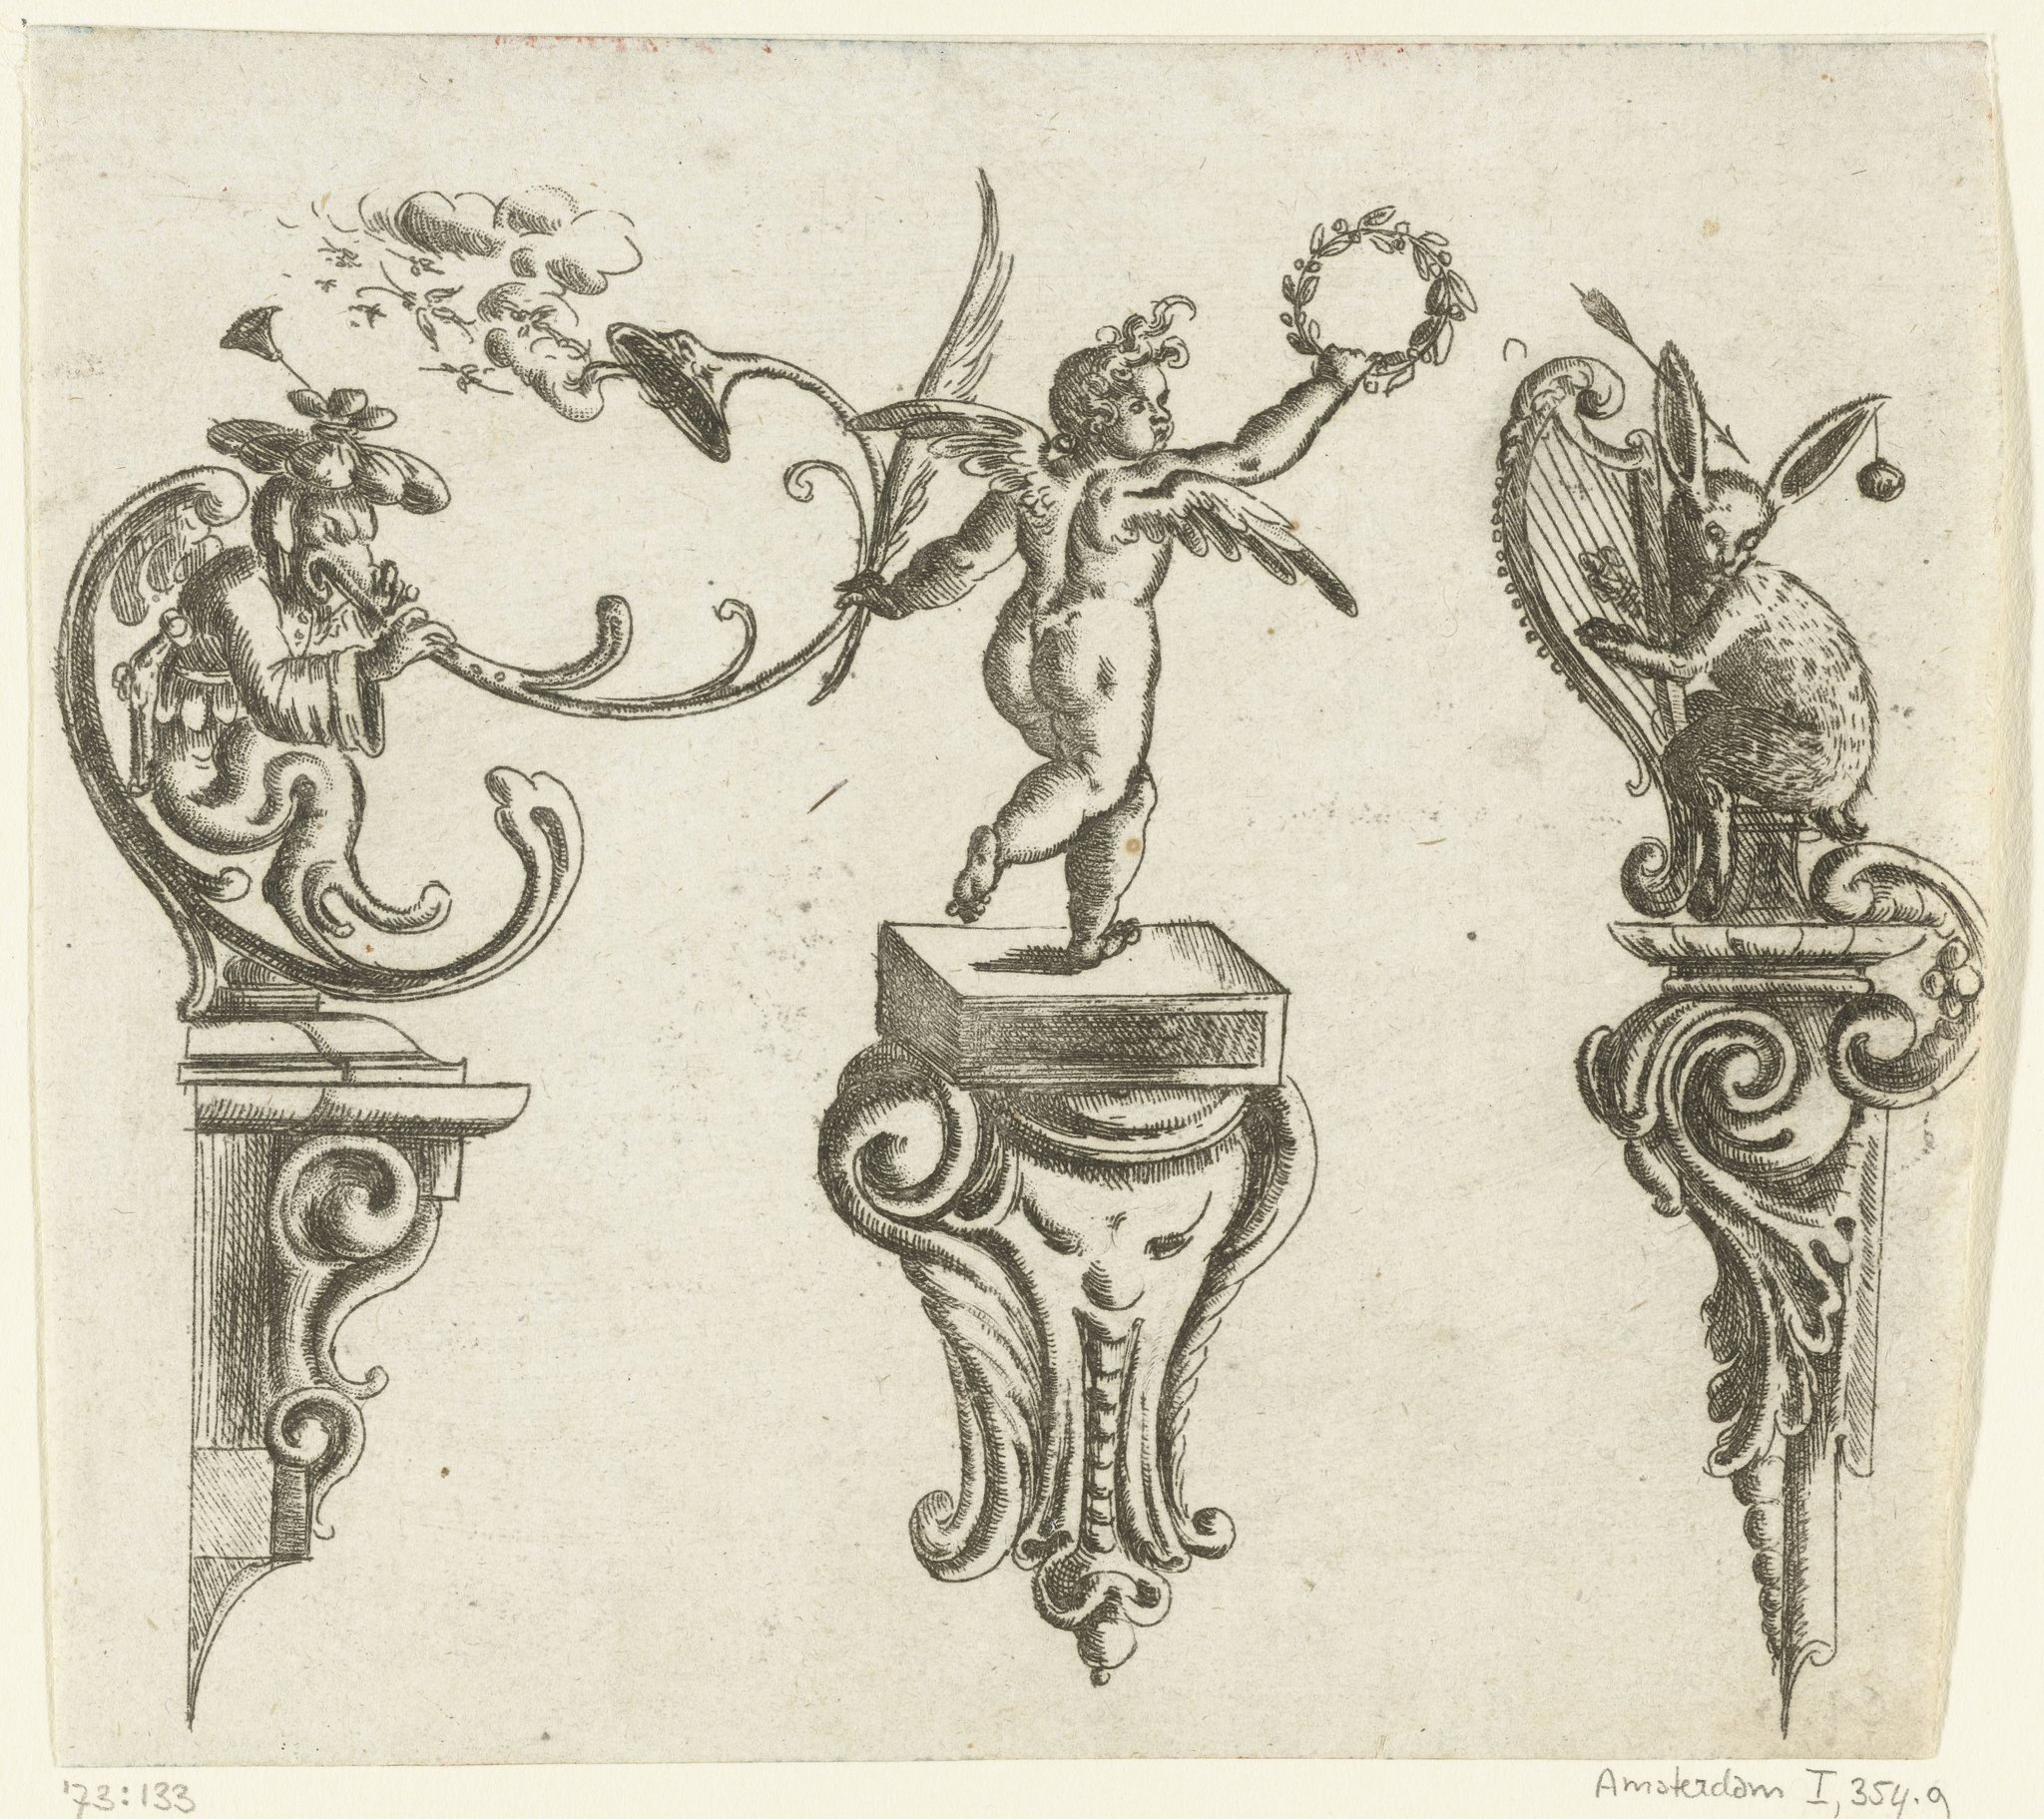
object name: ornament print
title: Drie consoles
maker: christoph jamnitzer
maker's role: draughtsman, goldsmith, print maker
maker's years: 1563-1618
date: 1573-1610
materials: paper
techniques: etching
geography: germany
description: Op de middelste console staat een putto met een palmtak en een lauwerkrans. Blad uit een serie vlakdecoraties met grotesken, cartouches, ovalen, mascarons, putti en fantastische wezens. De serie bestaat uit drie titelbladen, twee tekstbladen met de opdracht en het voorwoord en 60 bladen, verdeeld over drie boeken.